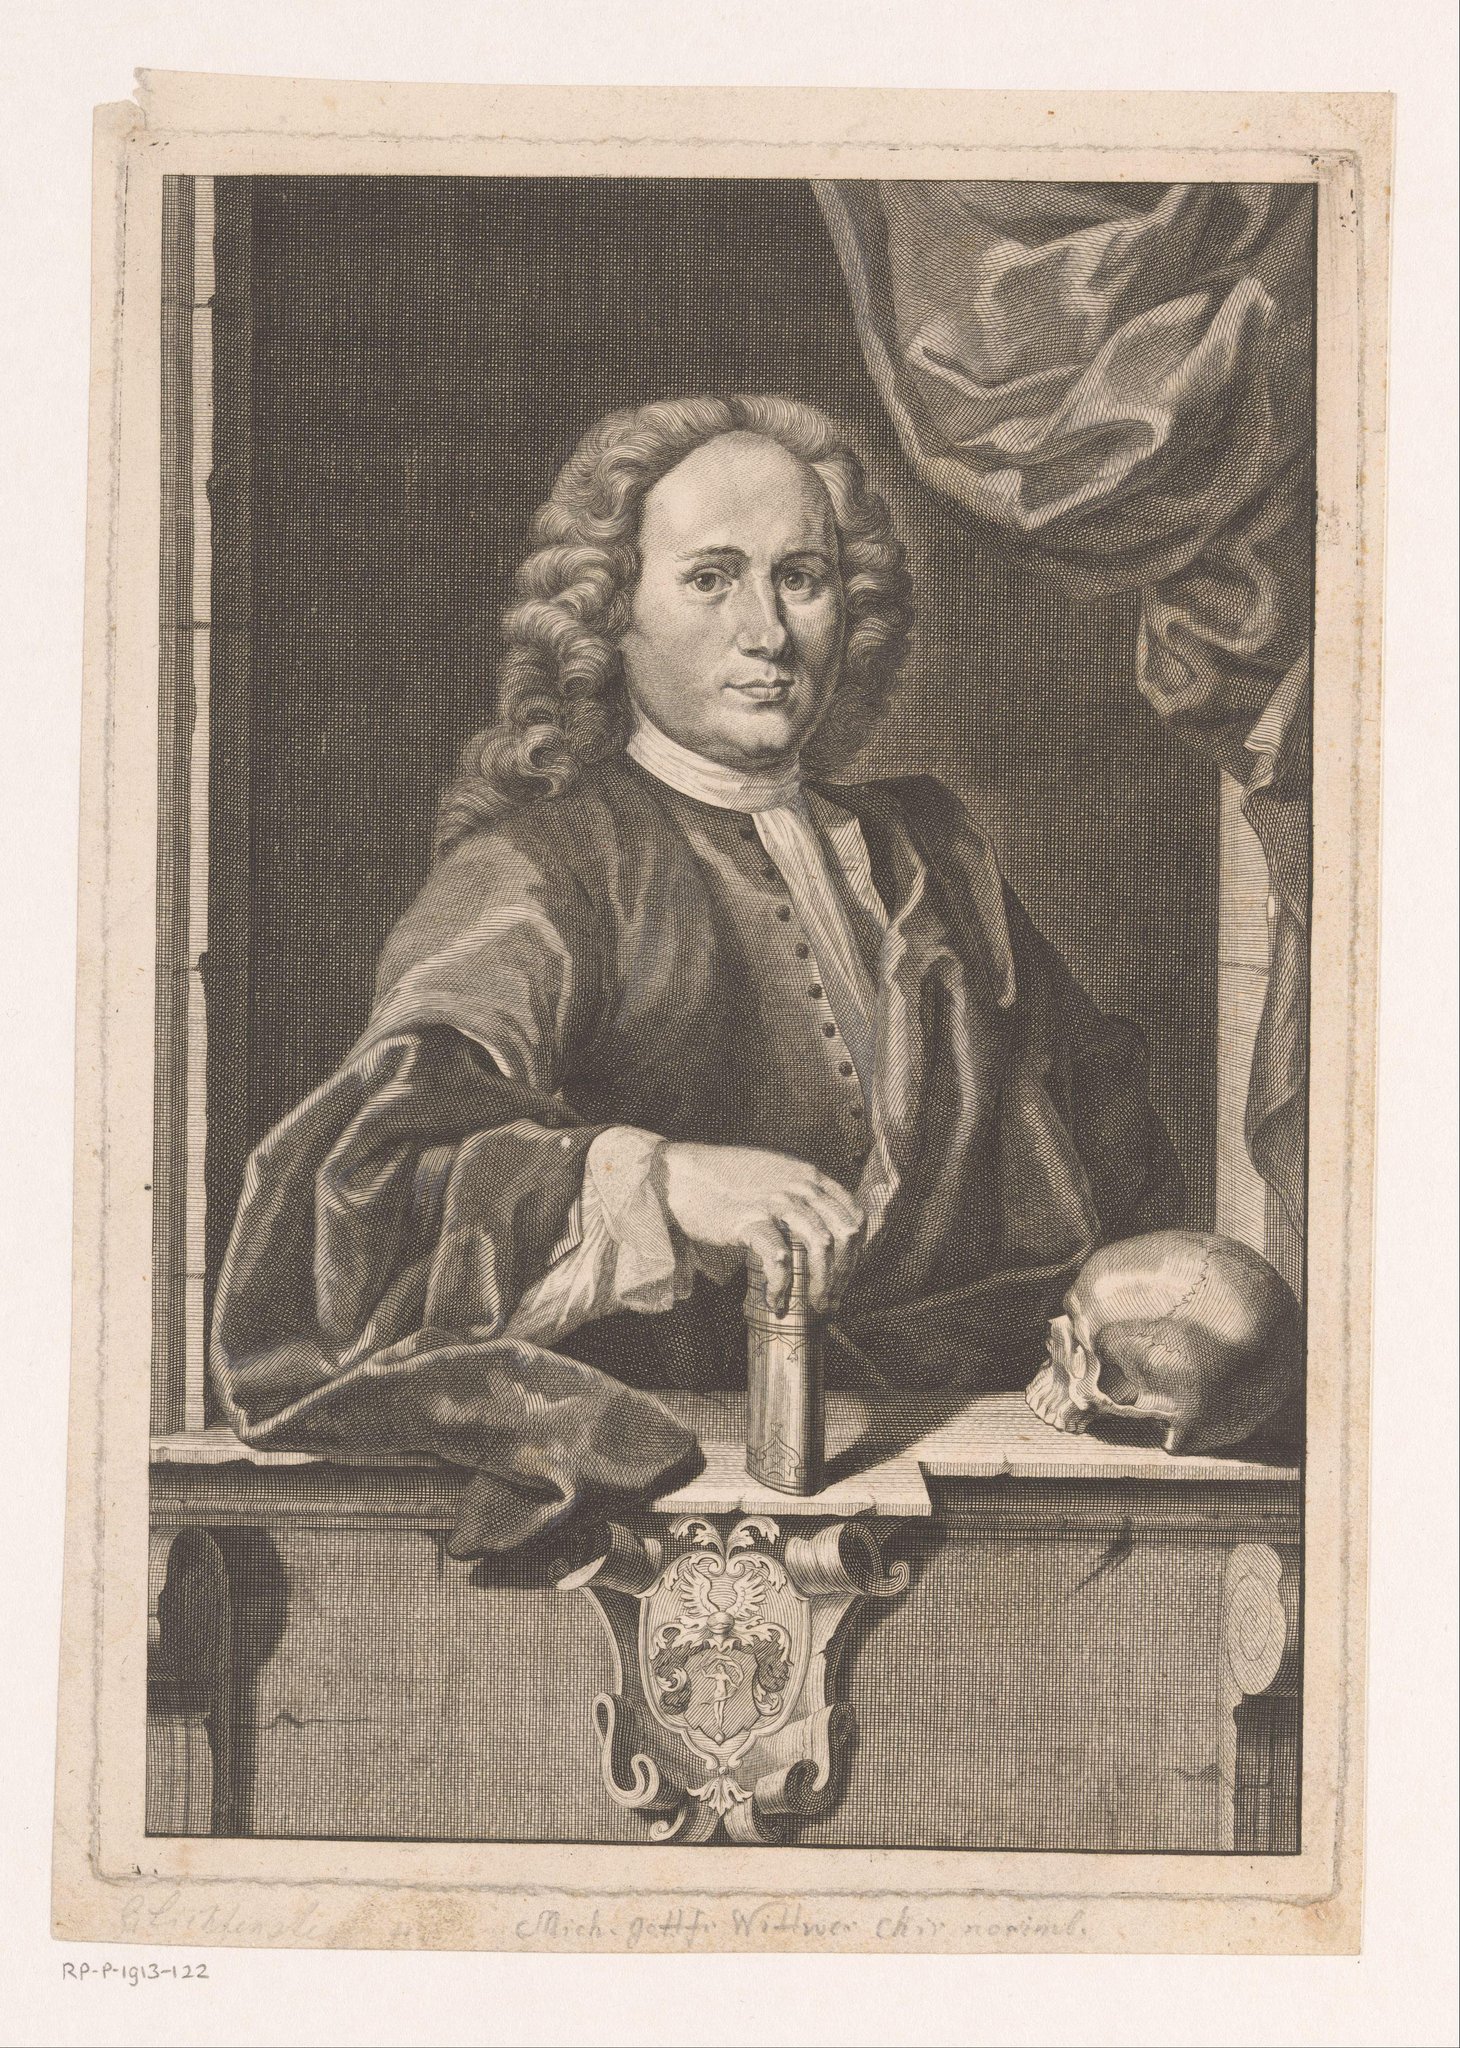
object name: print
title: Portret van Michael Gottfried Wittwer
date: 1725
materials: paper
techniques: engraving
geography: nuremberg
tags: historical persons, armorial bearing, heraldry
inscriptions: collector's mark: Lugt 2228